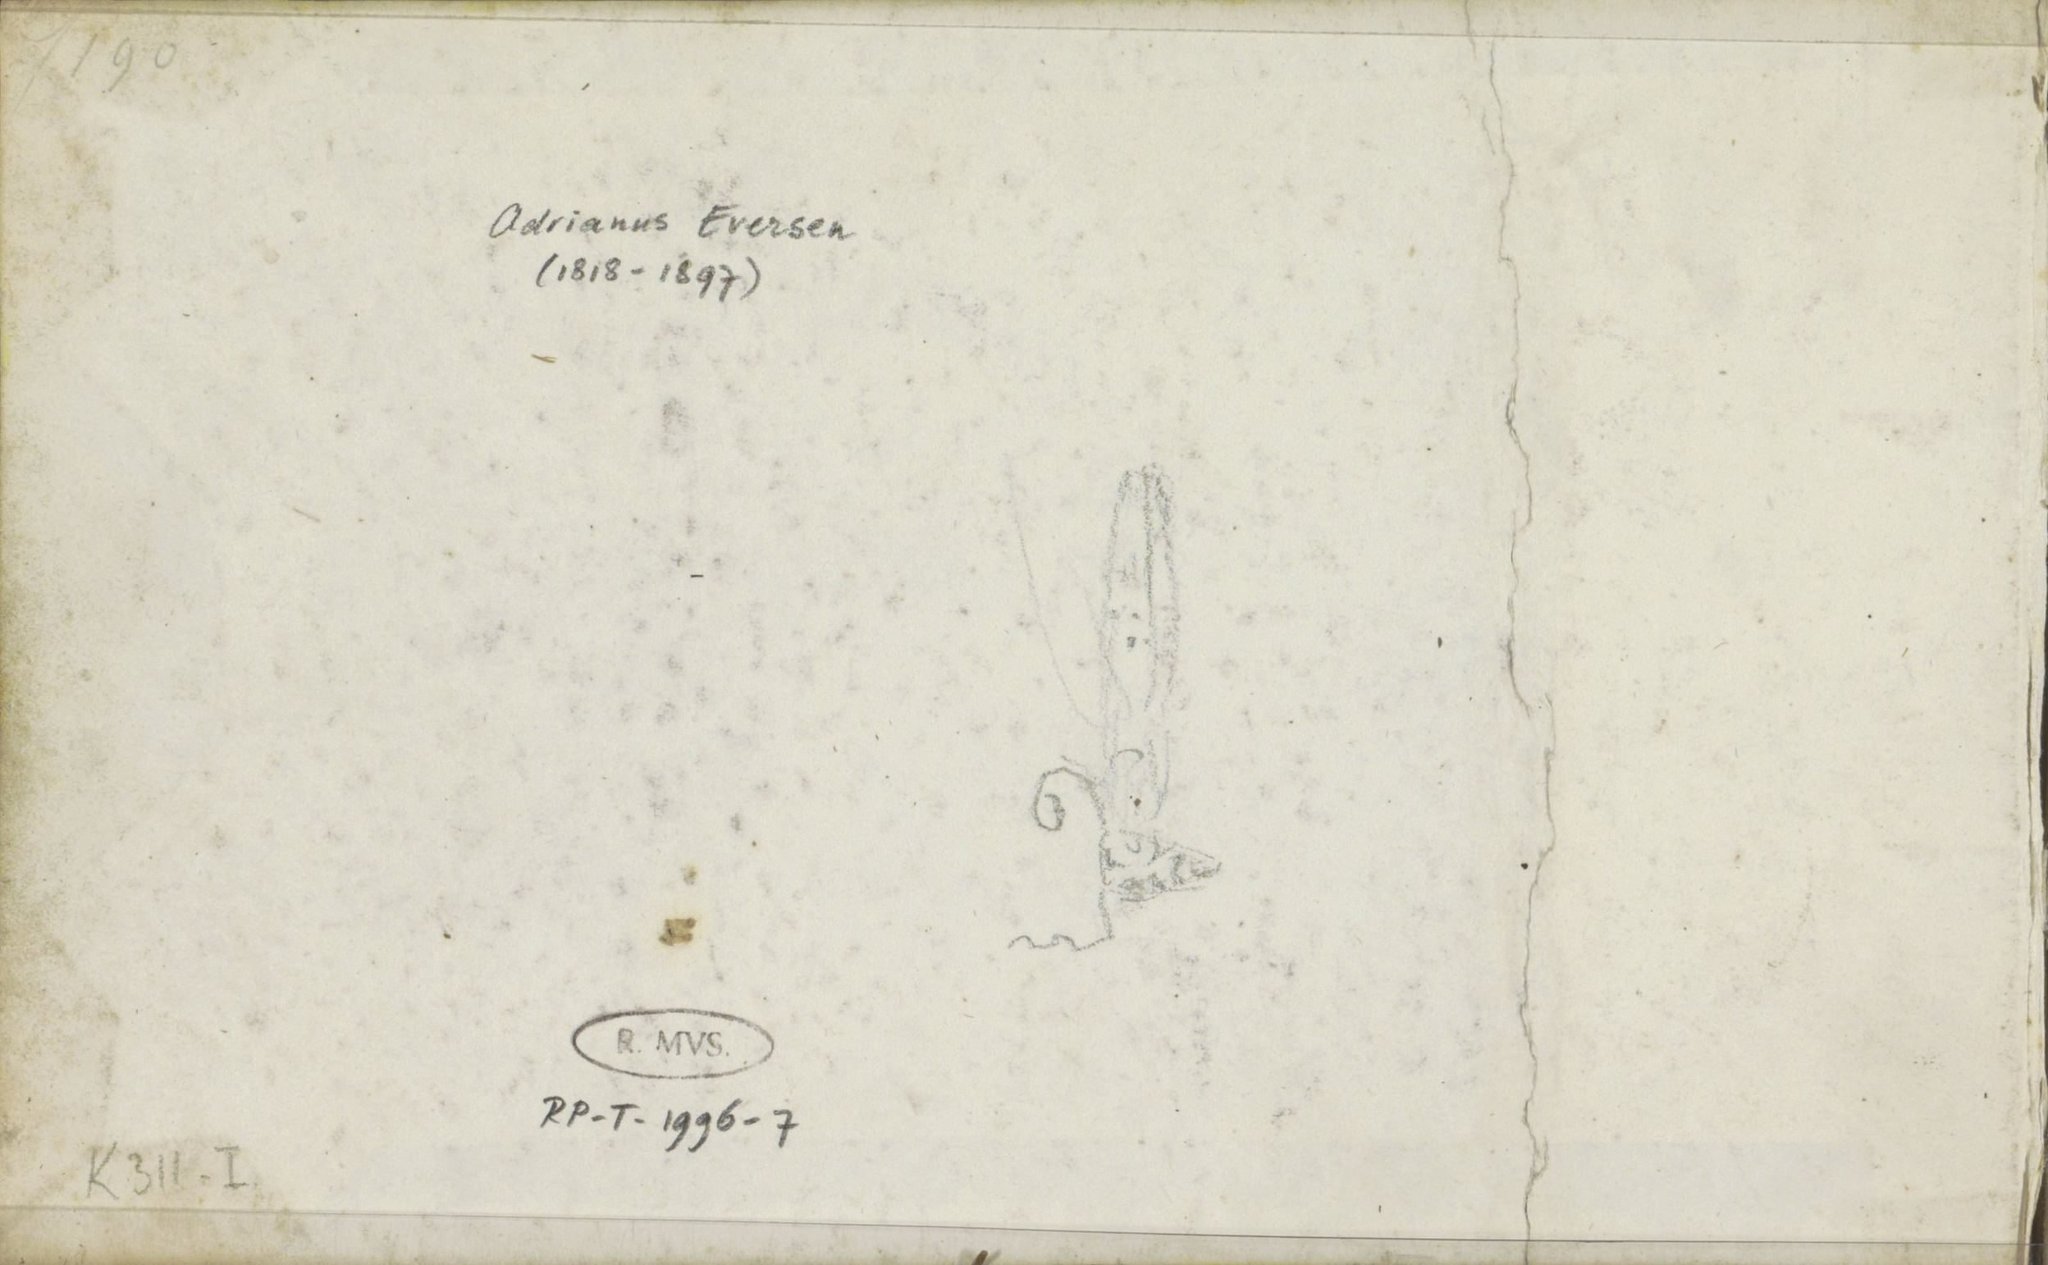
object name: endleaf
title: Insect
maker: adrianus eversen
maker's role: draughtsman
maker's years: 1818-1897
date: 1828-1897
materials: paper, pencil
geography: netherlands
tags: insects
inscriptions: collector's mark: Lugt 2228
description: Insect. Voorste schutblad uit een schetsboek met 27 bladen.